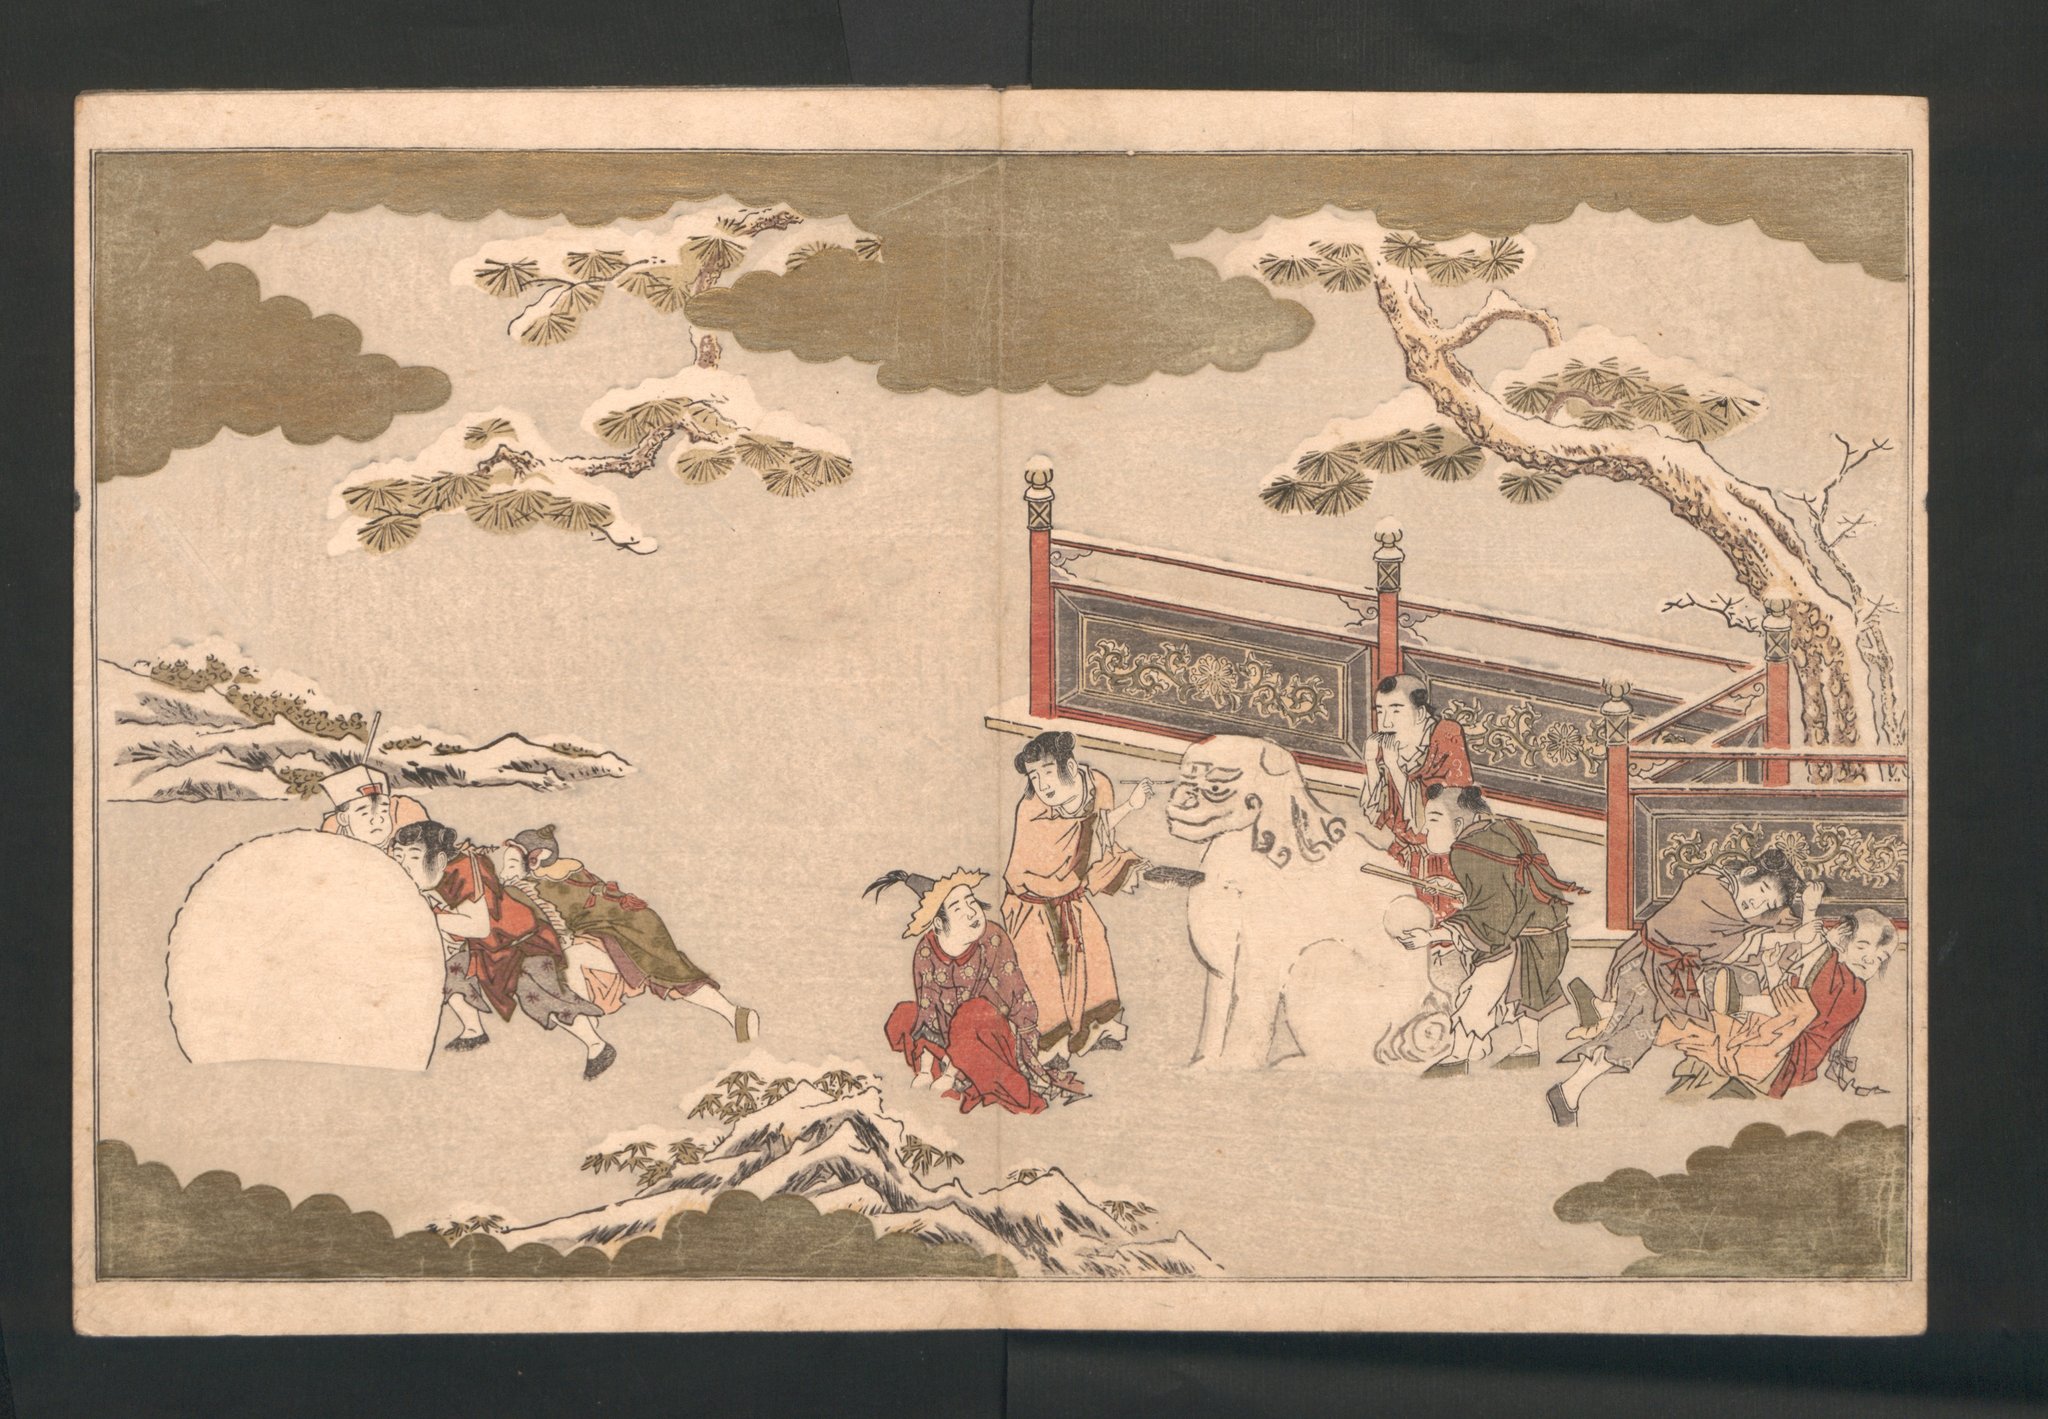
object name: illustrated book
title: The Silver World (Gin sekai) 銀世界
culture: japanese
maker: 喜多川歌麿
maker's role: artist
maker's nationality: japanese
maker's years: 1754-1806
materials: ink, paper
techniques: polychrome, woodblock print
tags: human figures,moon,trees,snow